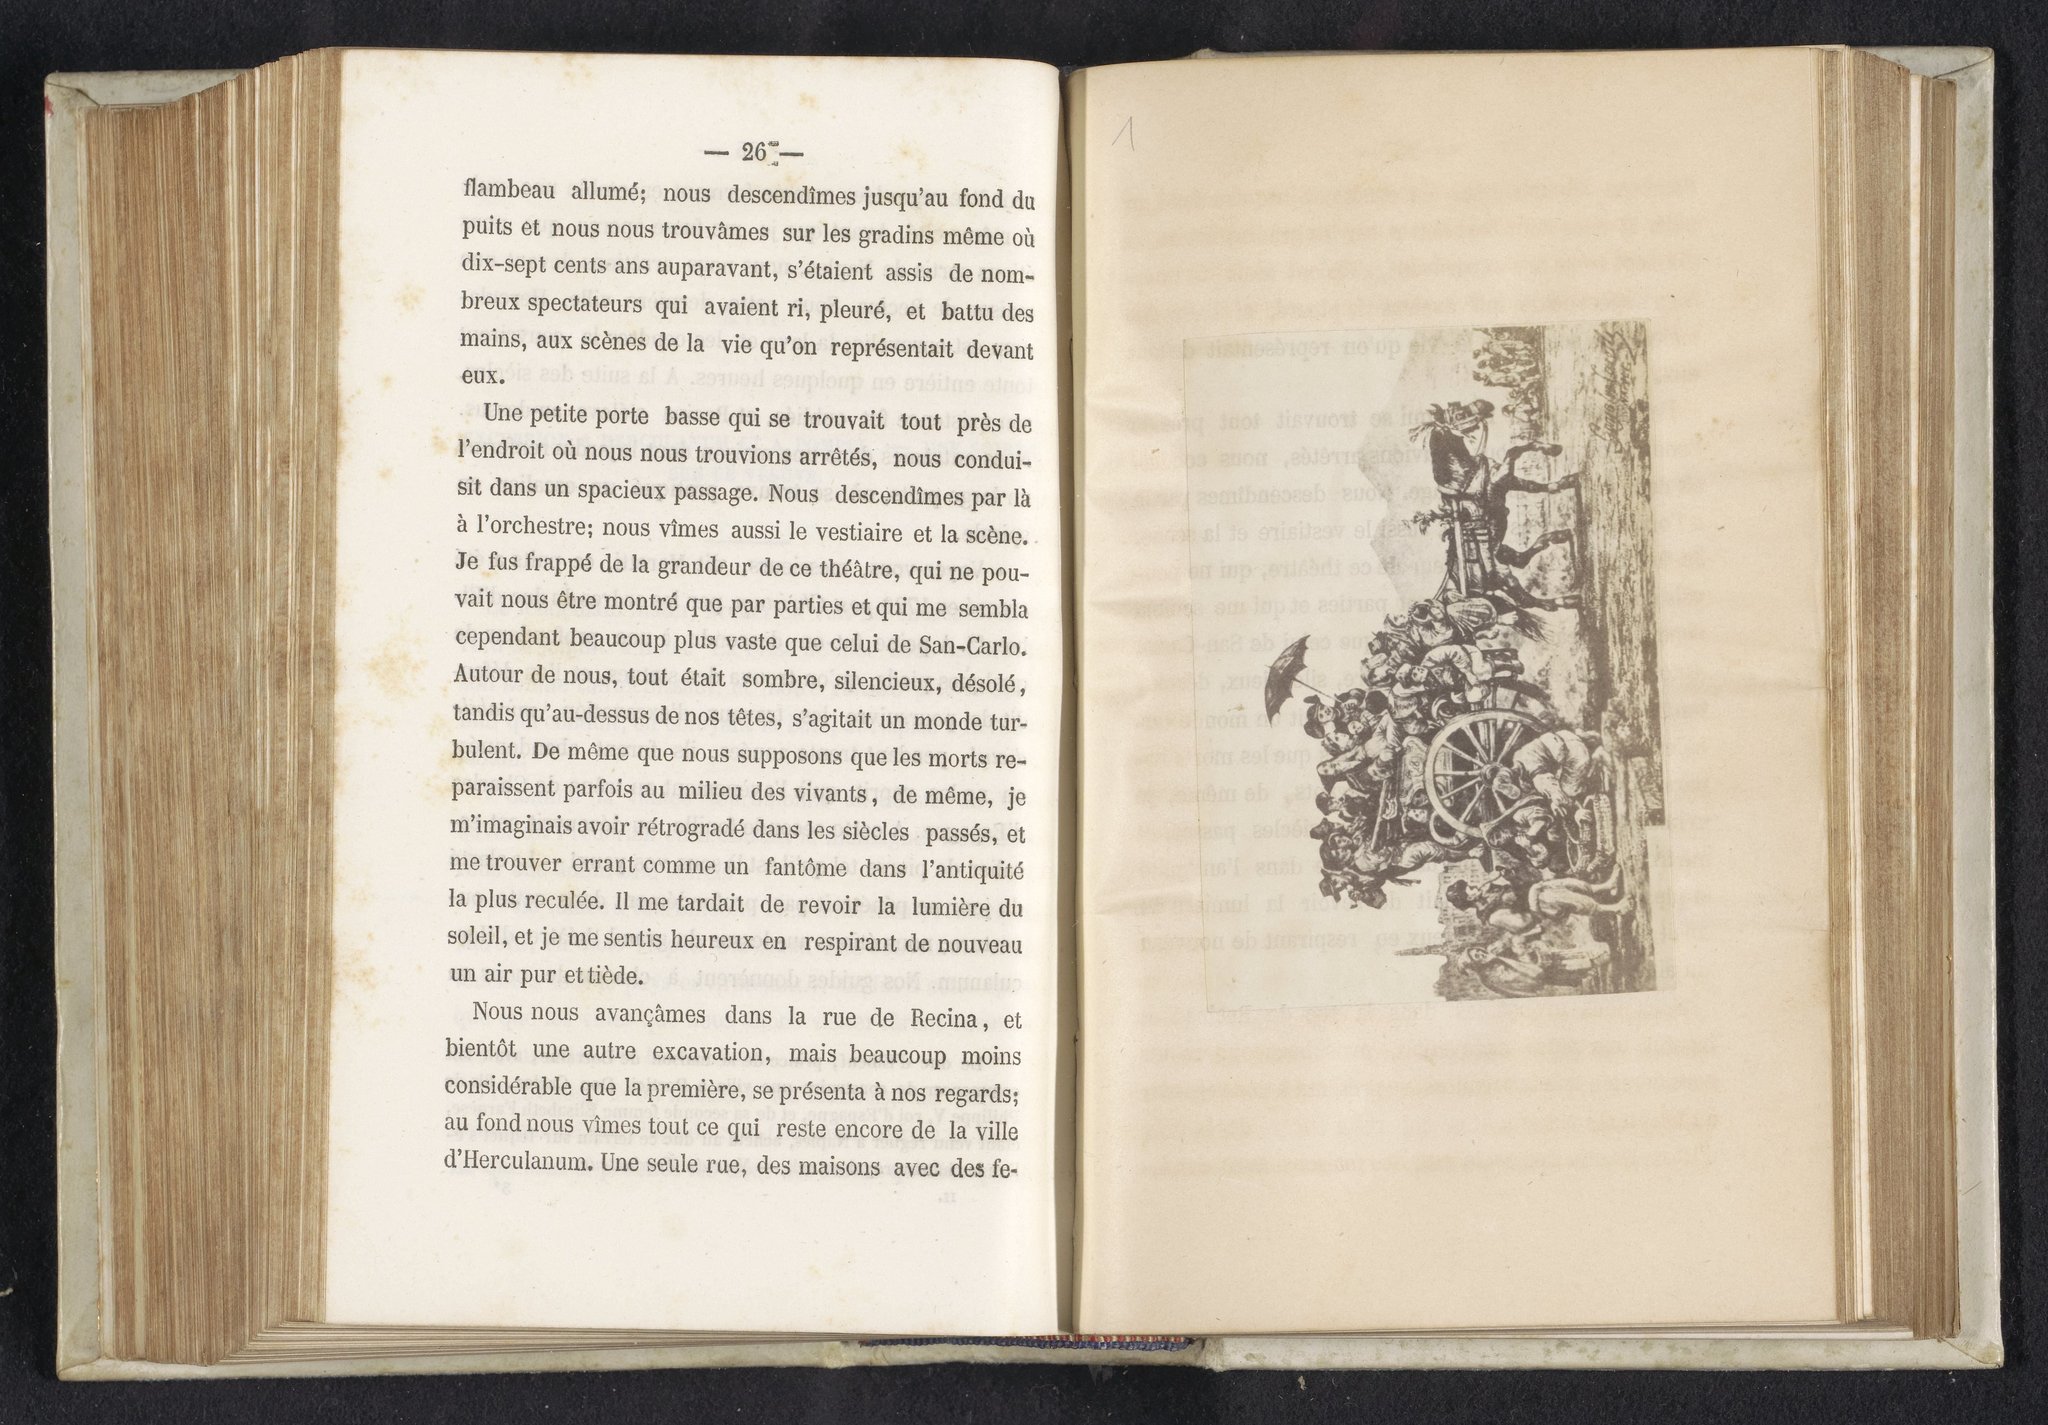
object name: page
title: Fotoreproductie van een schilderij, voorstellende een groep mensen op een paardenkar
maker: Anonymous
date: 1850-1860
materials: photographic support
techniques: albumen print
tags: horse, (farm) wagon, freight wagon, cart